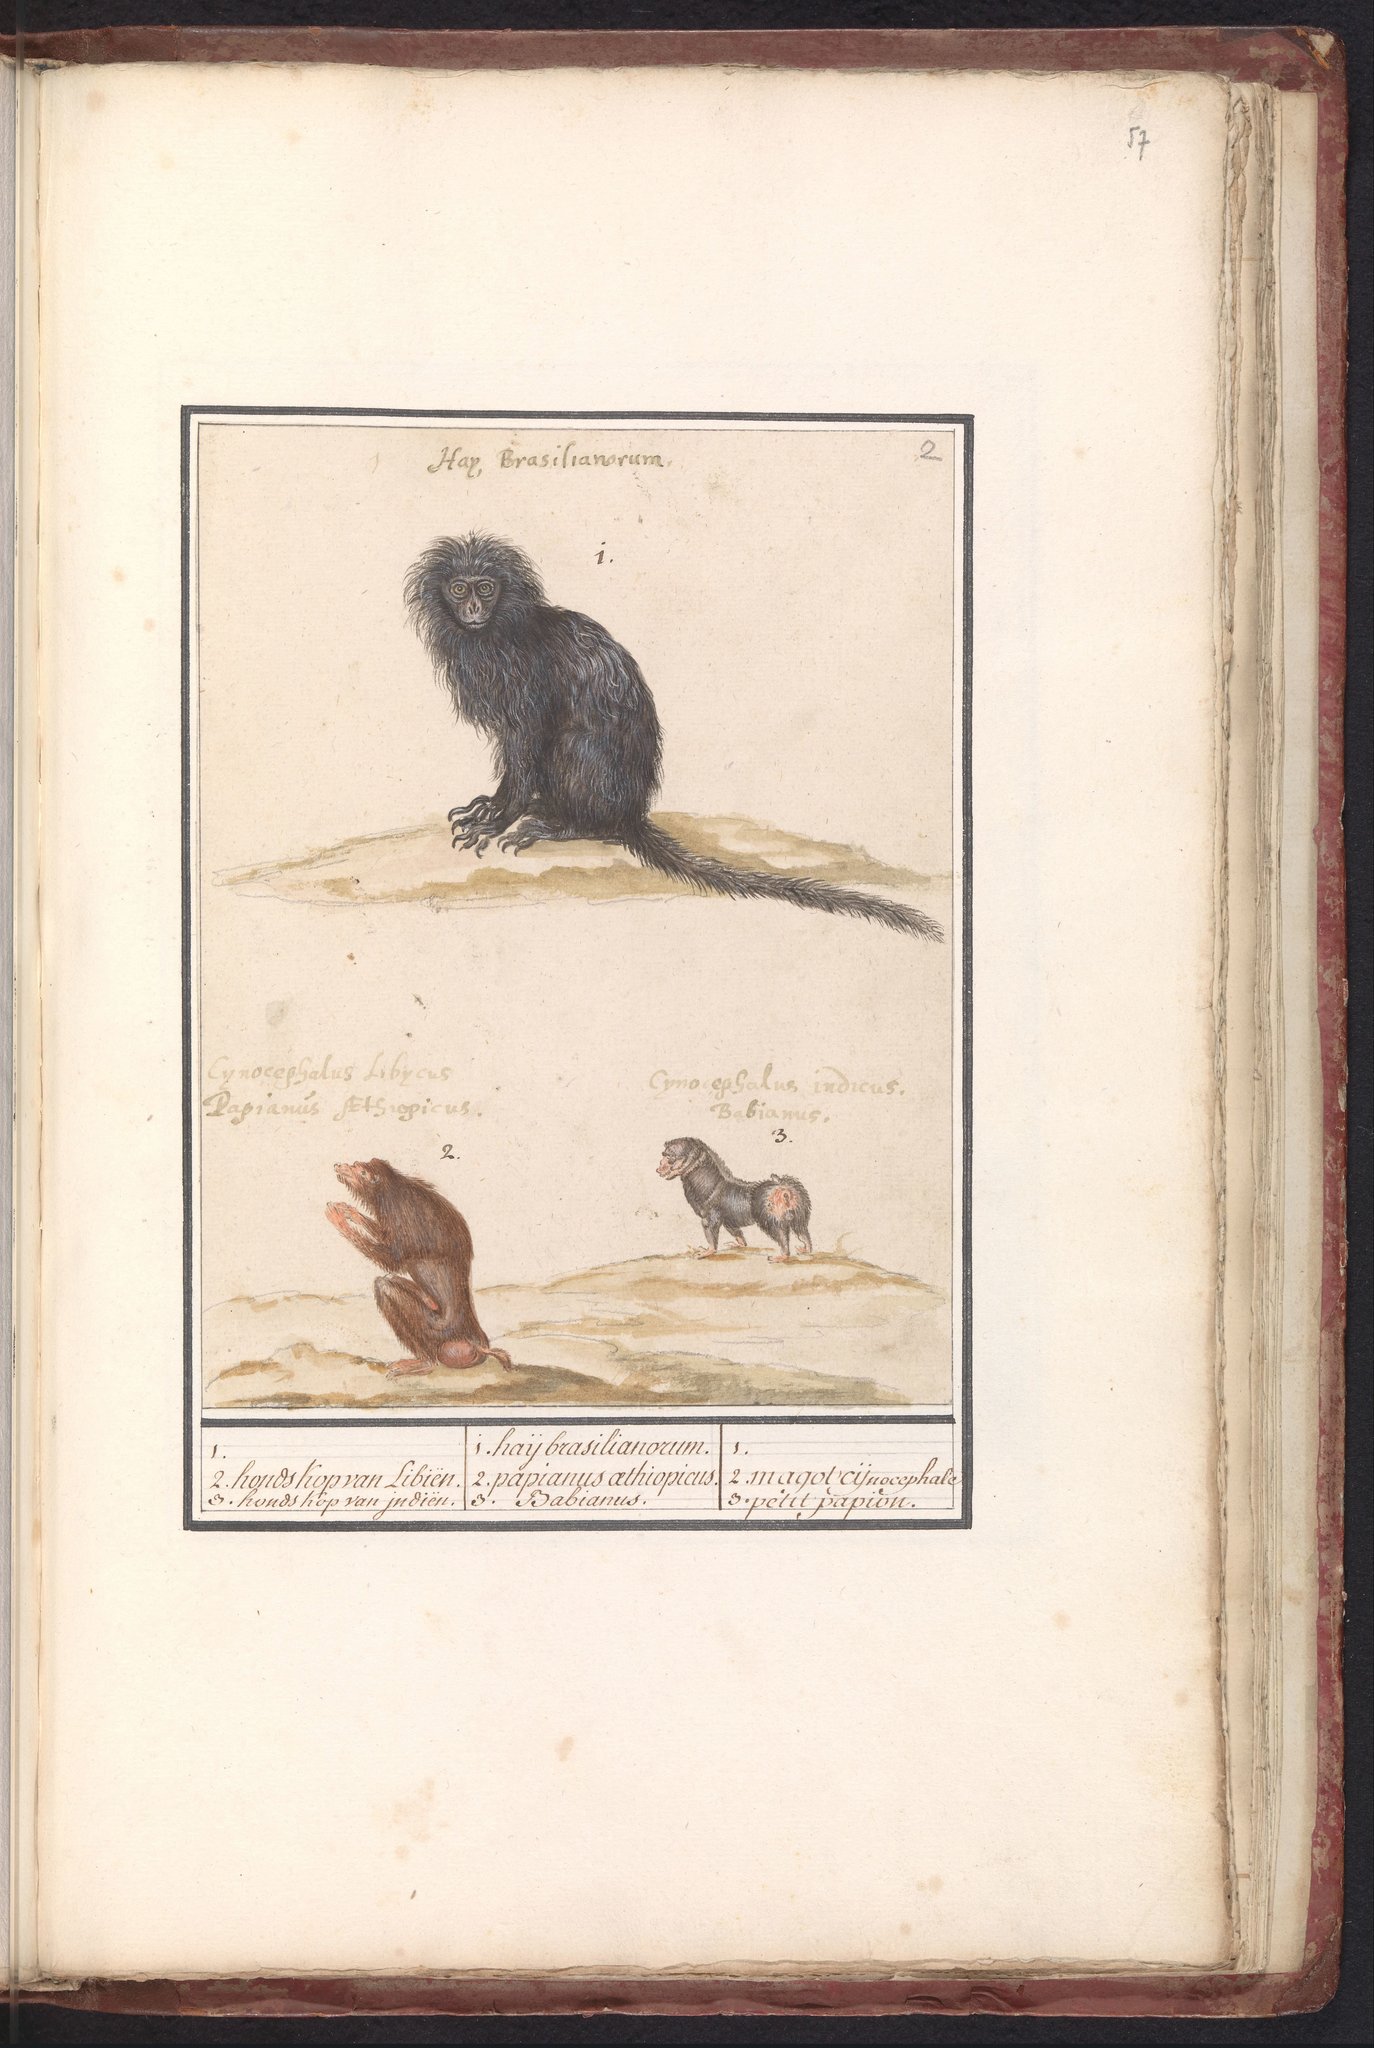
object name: drawing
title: Aap en twee bavianen (Papio)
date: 1596-1610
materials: paint, ink, paper, pencil, watercolor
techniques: brush, pen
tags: monkeys, apes: baboon, monkeys, apes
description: Een zwarte Barziliaanse aap (mogelijk een zwarte slingeraap) en twee bavianen. Genummerd rechtsboven: 2. Met opschriften in het Latijn. Onderdeel van het tweede album met tekeningen van viervoeters. Tweede van twaalf albums met tekeningen van dieren, vogels en planten bekend rond 1600, gemaakt in opdracht van keizer Rudolf II. Met toelichting in Nederlands, Latijn en Frans.